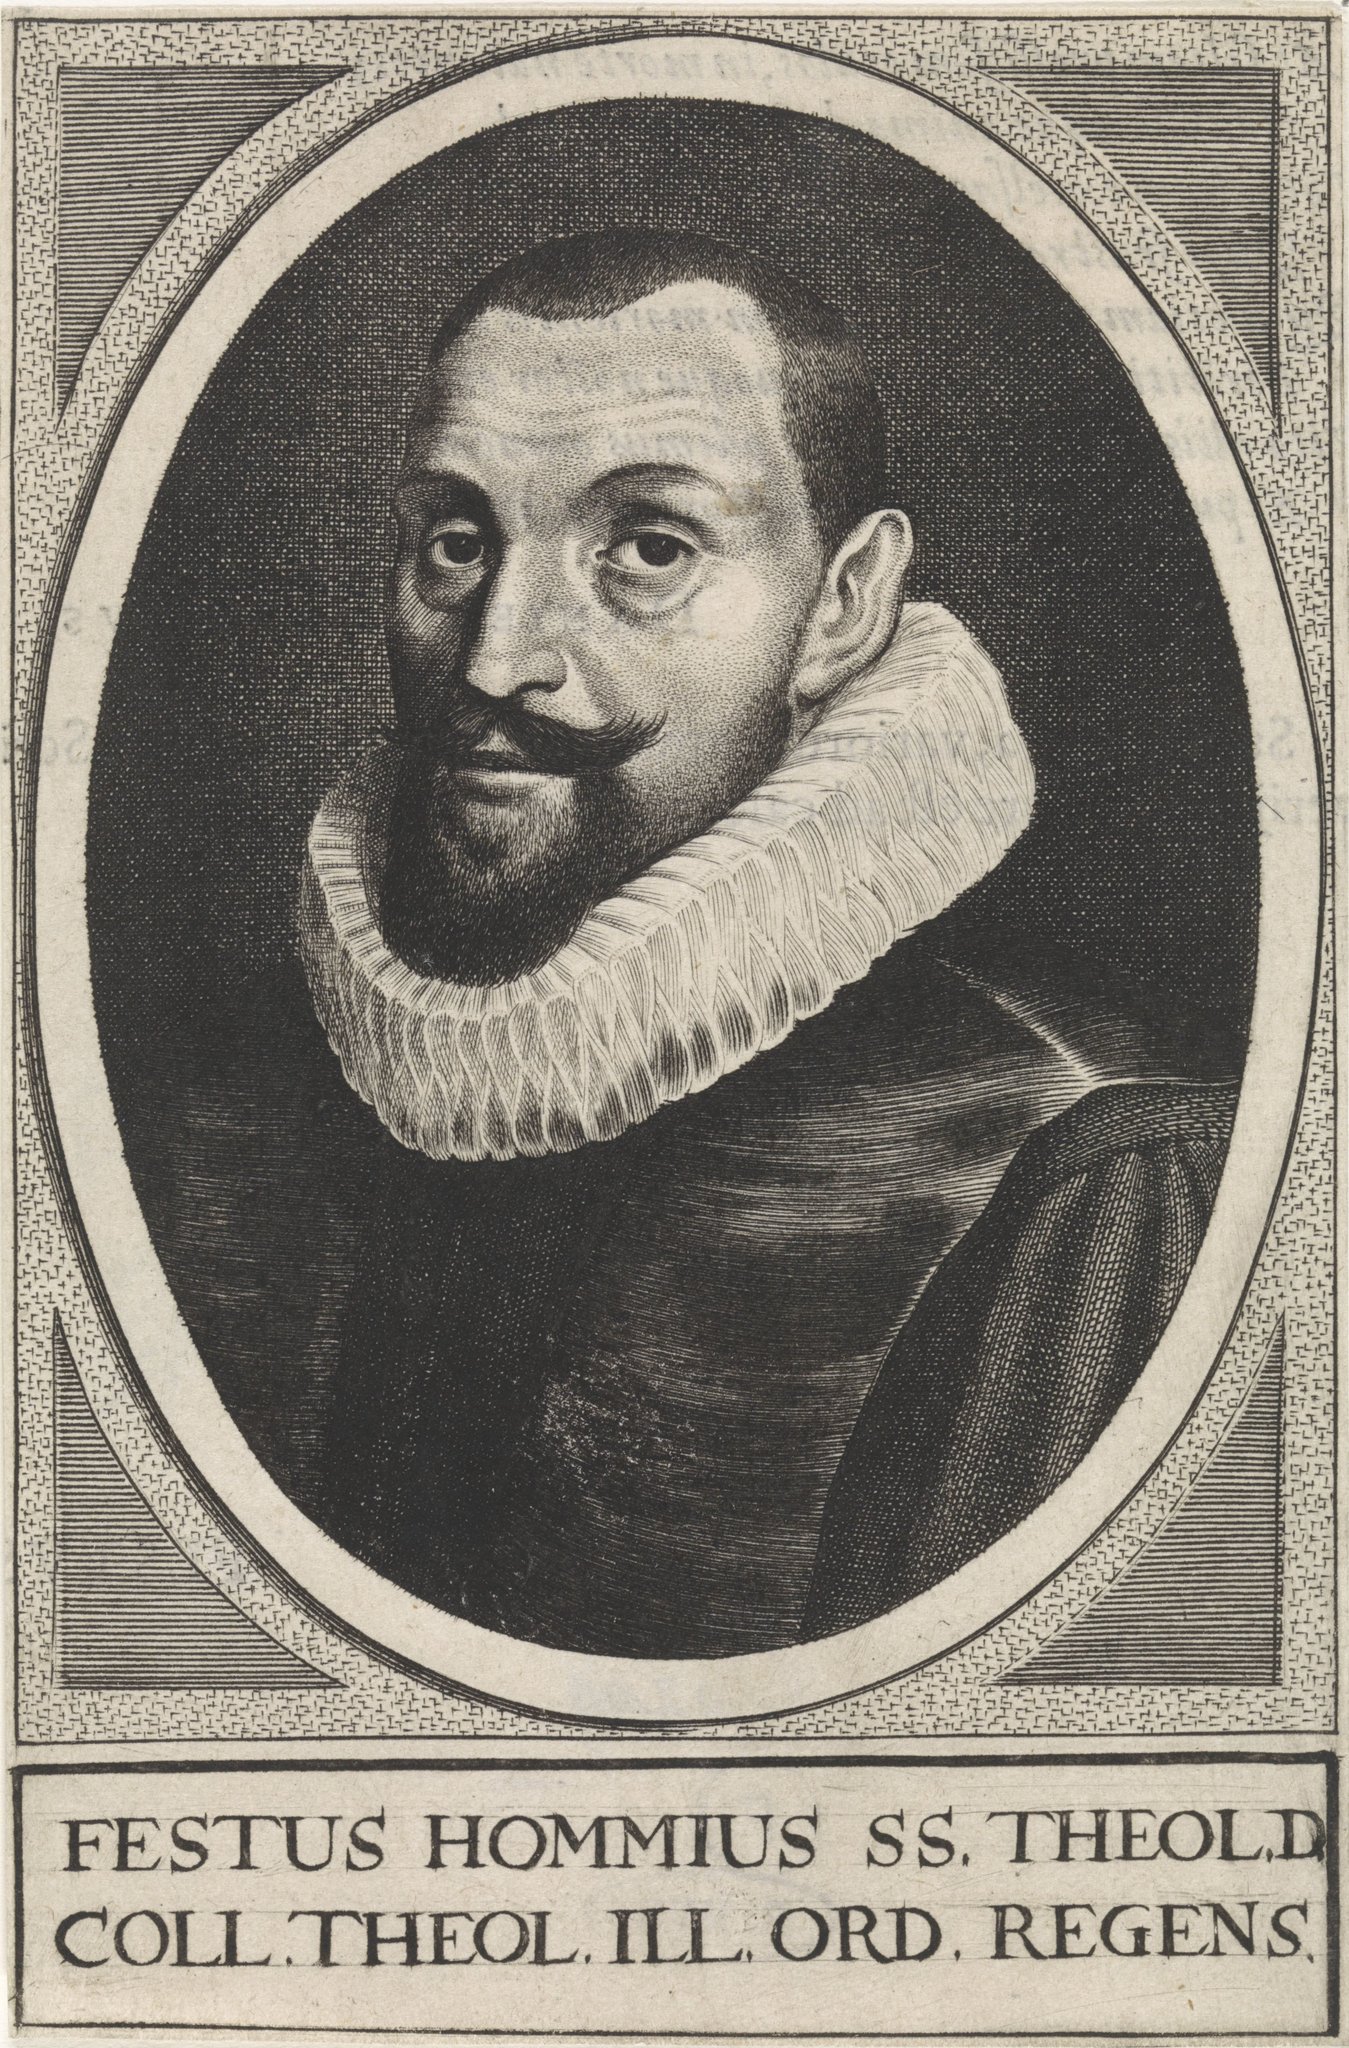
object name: print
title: Portret van Festus Hommius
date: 1625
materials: paper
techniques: engraving, letterpress printing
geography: leiden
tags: leiden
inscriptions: collector's mark: Lugt 964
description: Boekillustratie in: Meursius, Joannes. Athenæ Batavæ. Sive, De vrbe Leidensi, & academiâ, virisque claris. Leiden: Andries Clouck, Bonaventura en Abraham Elzevier, 1625. Abusievelijk tweemaal gecatalogiseerd bij Franken & Van der Kellen.